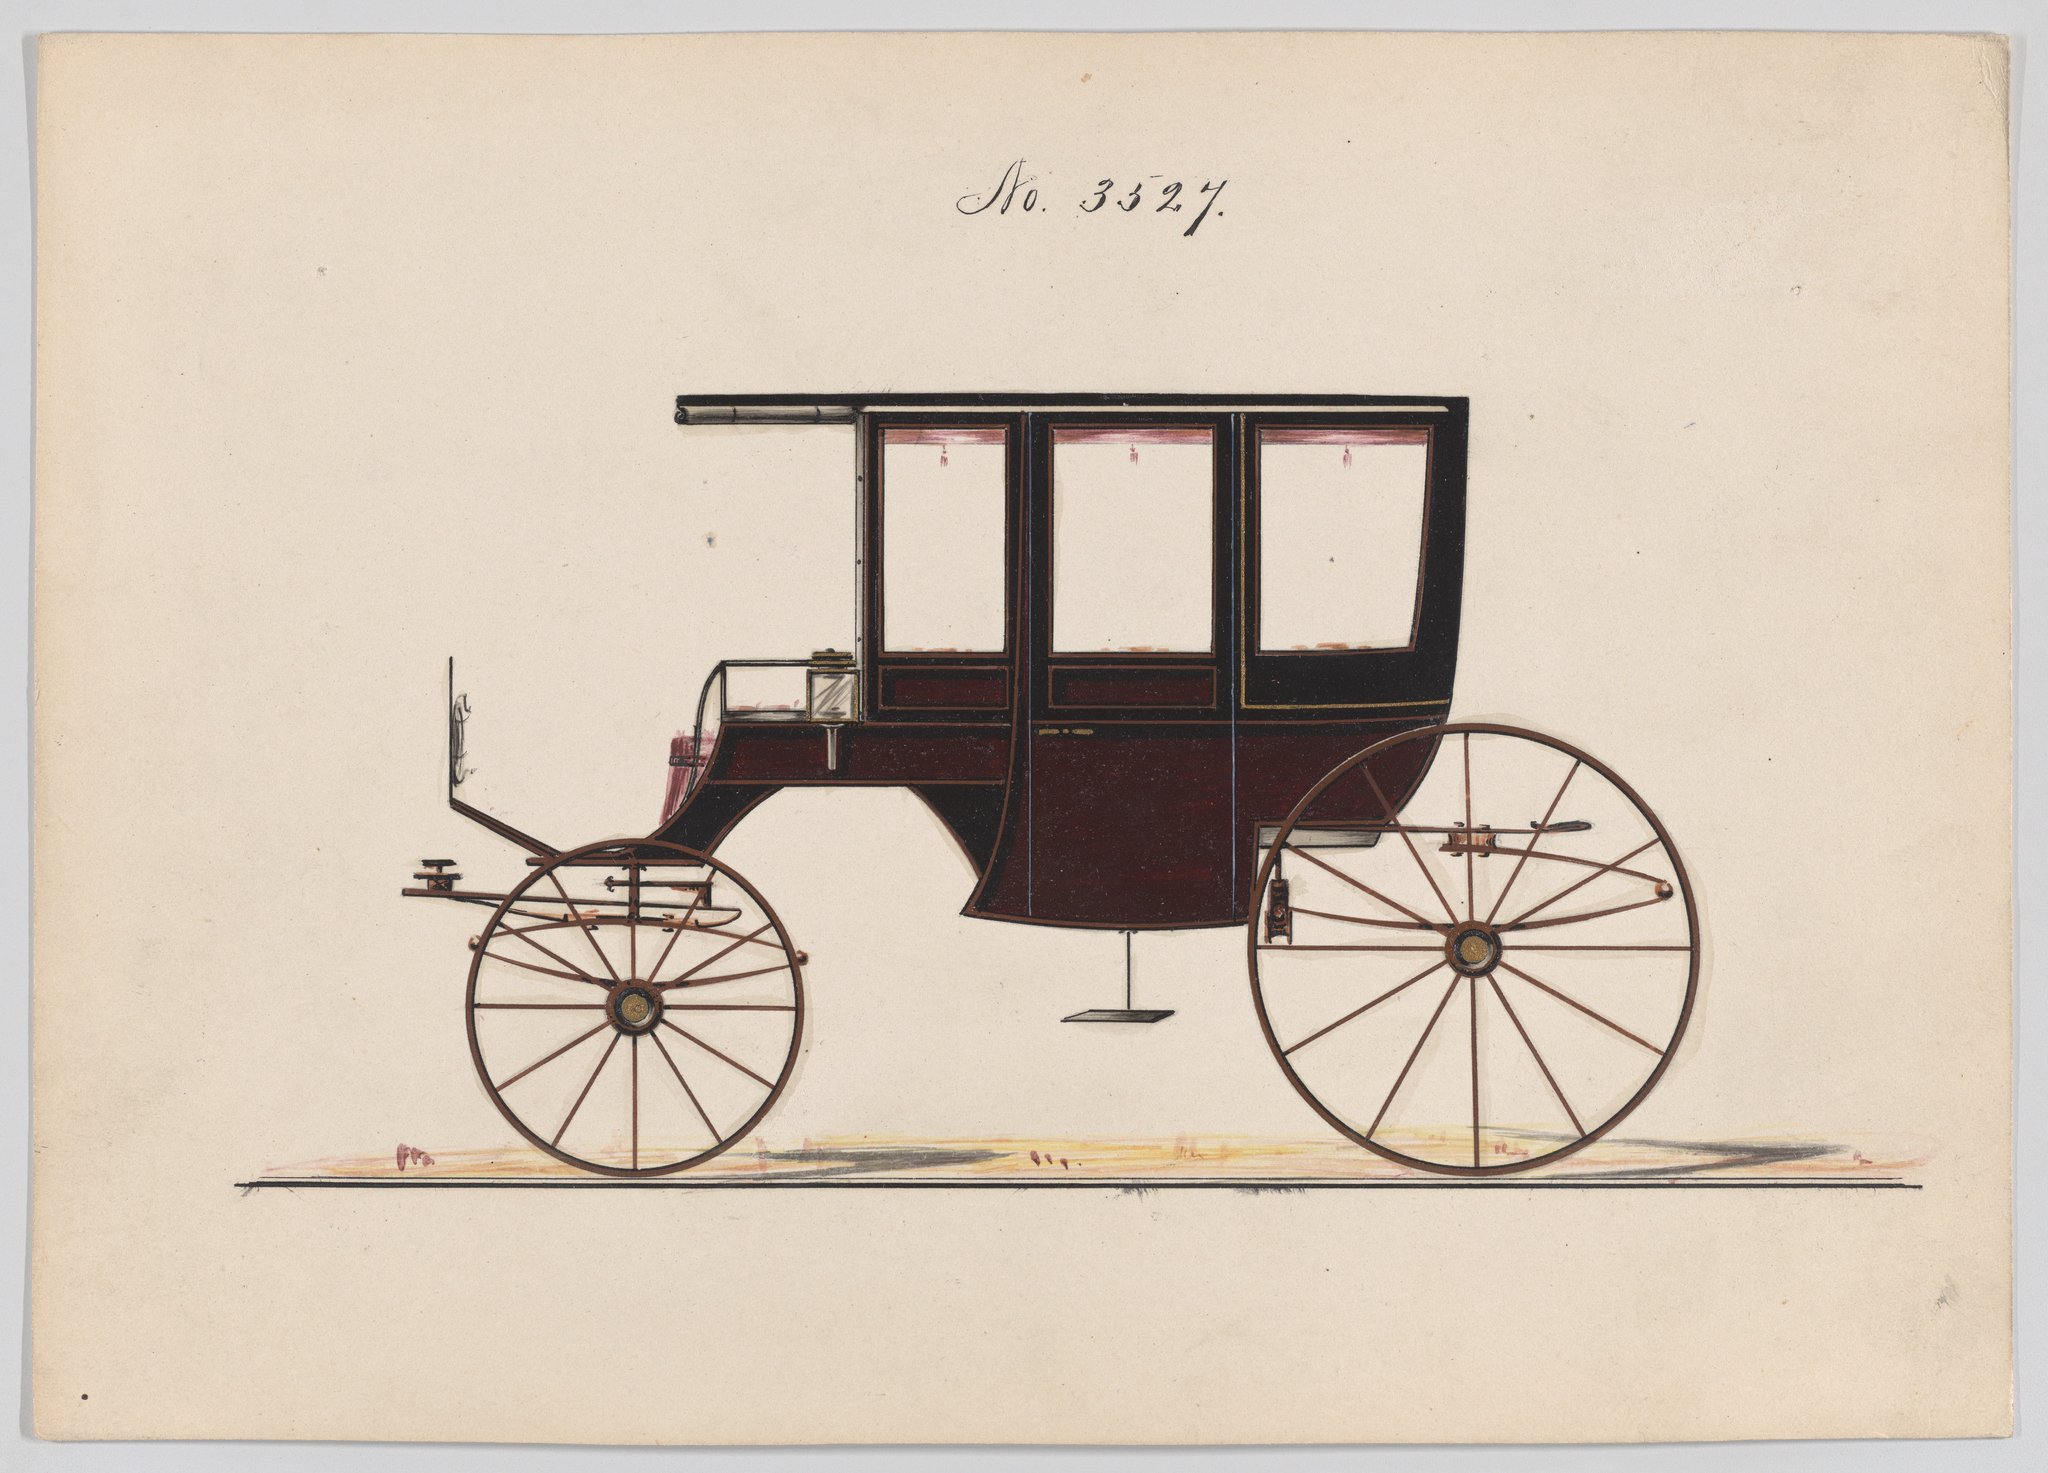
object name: drawing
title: Design for 6 seat Rockaway, no. 3527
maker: brewster & co.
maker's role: manufacturer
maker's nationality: american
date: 1879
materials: gouache, ink, watercolor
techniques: pen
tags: carriages